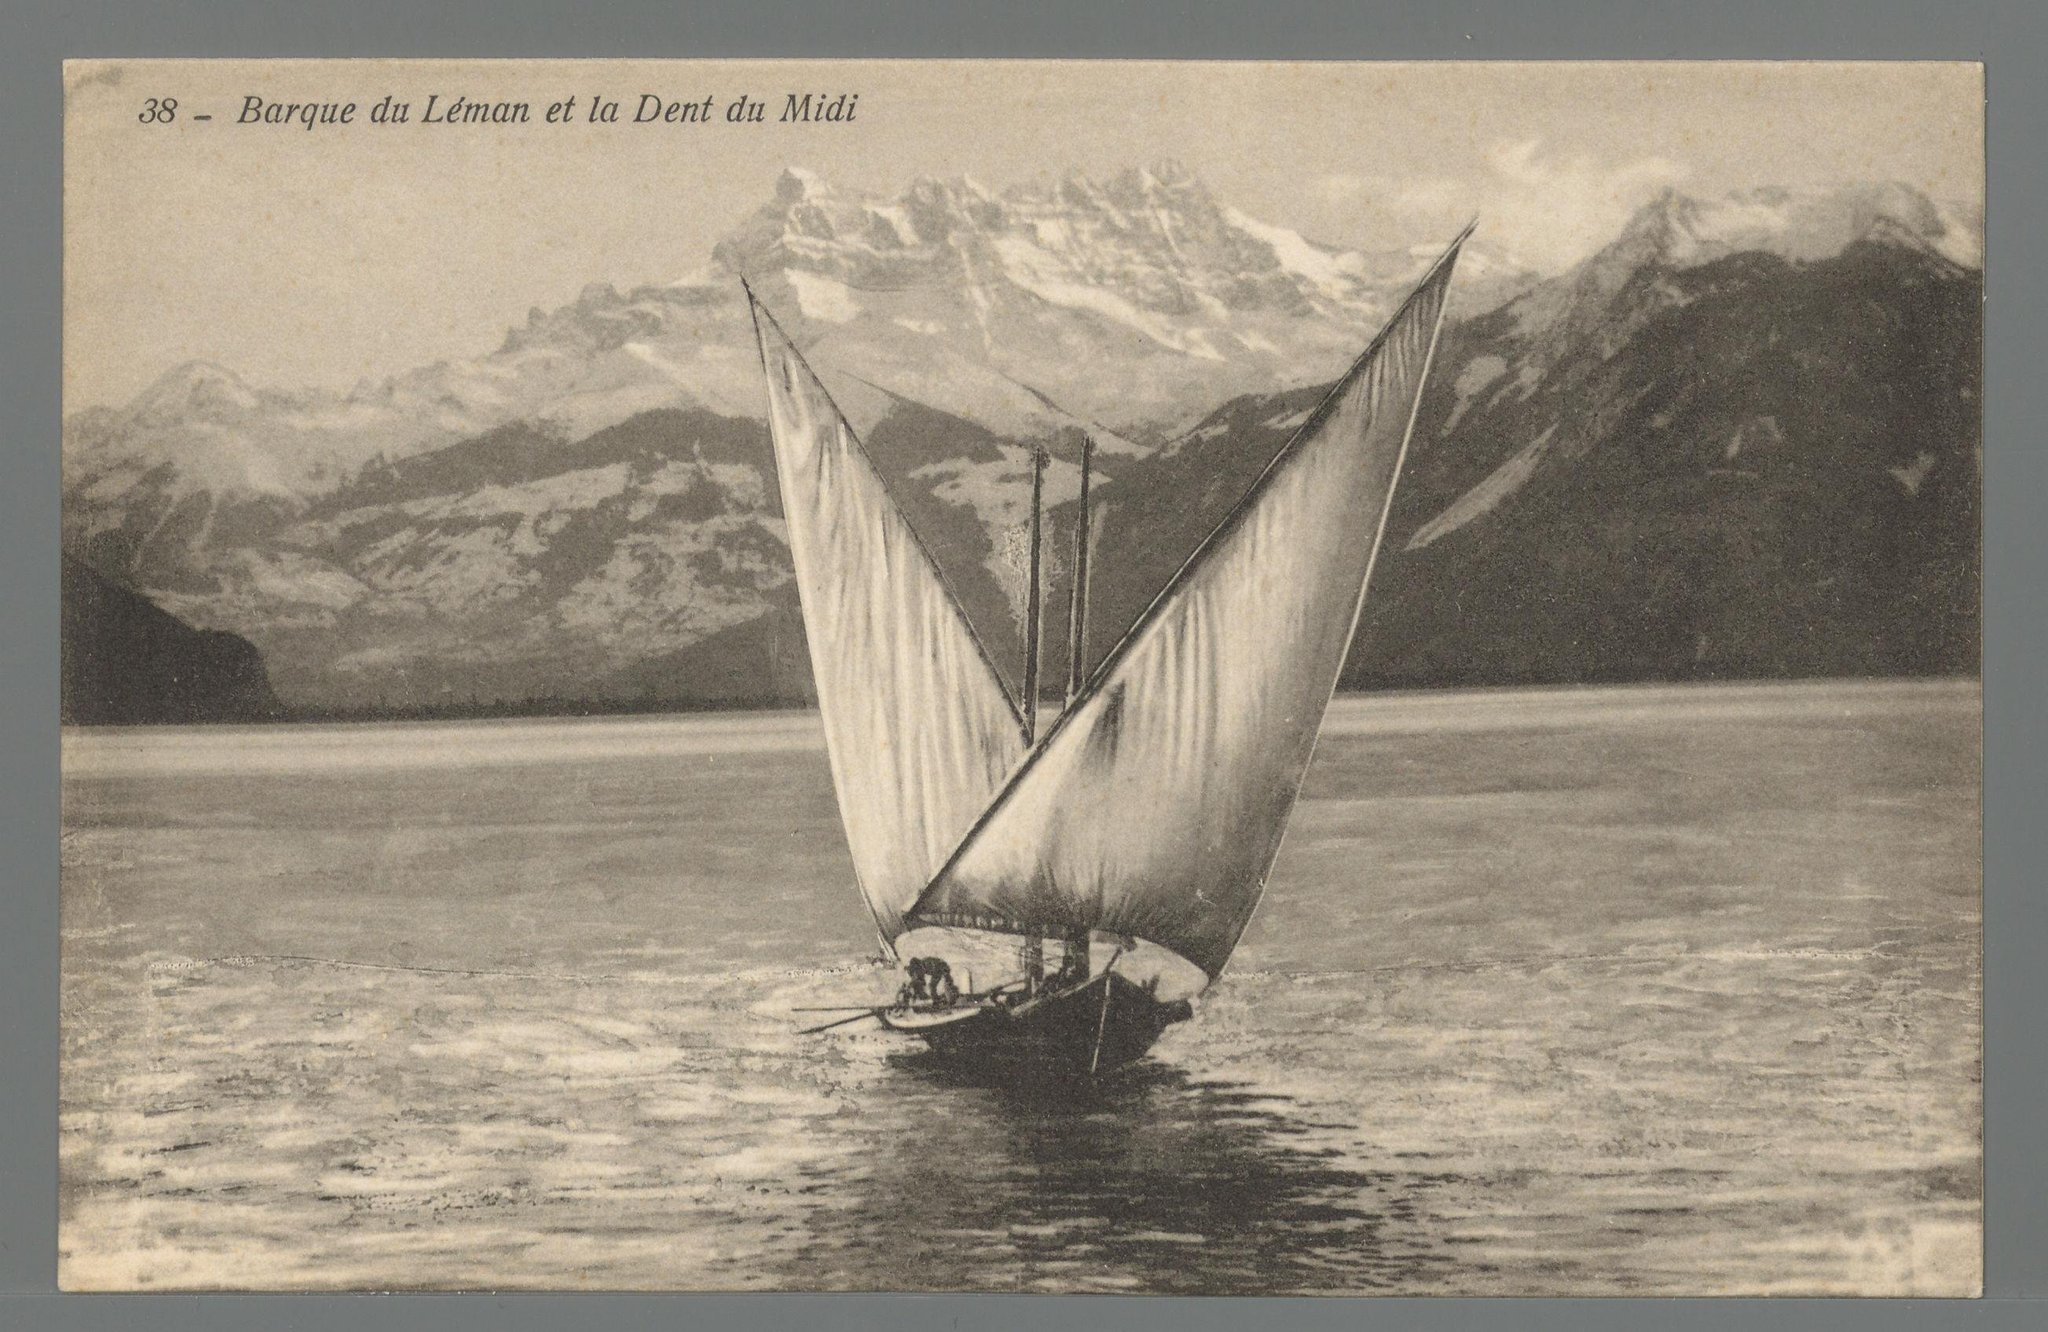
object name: ansichtkaart, prentbriefkaart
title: Barque du Léman et la Dent du Mdi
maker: Anonymous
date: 1905-1909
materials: cardboard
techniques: photograph, writing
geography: geneva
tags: sailing-ship, sailing-boat, lake, mountain-range, snow peaks